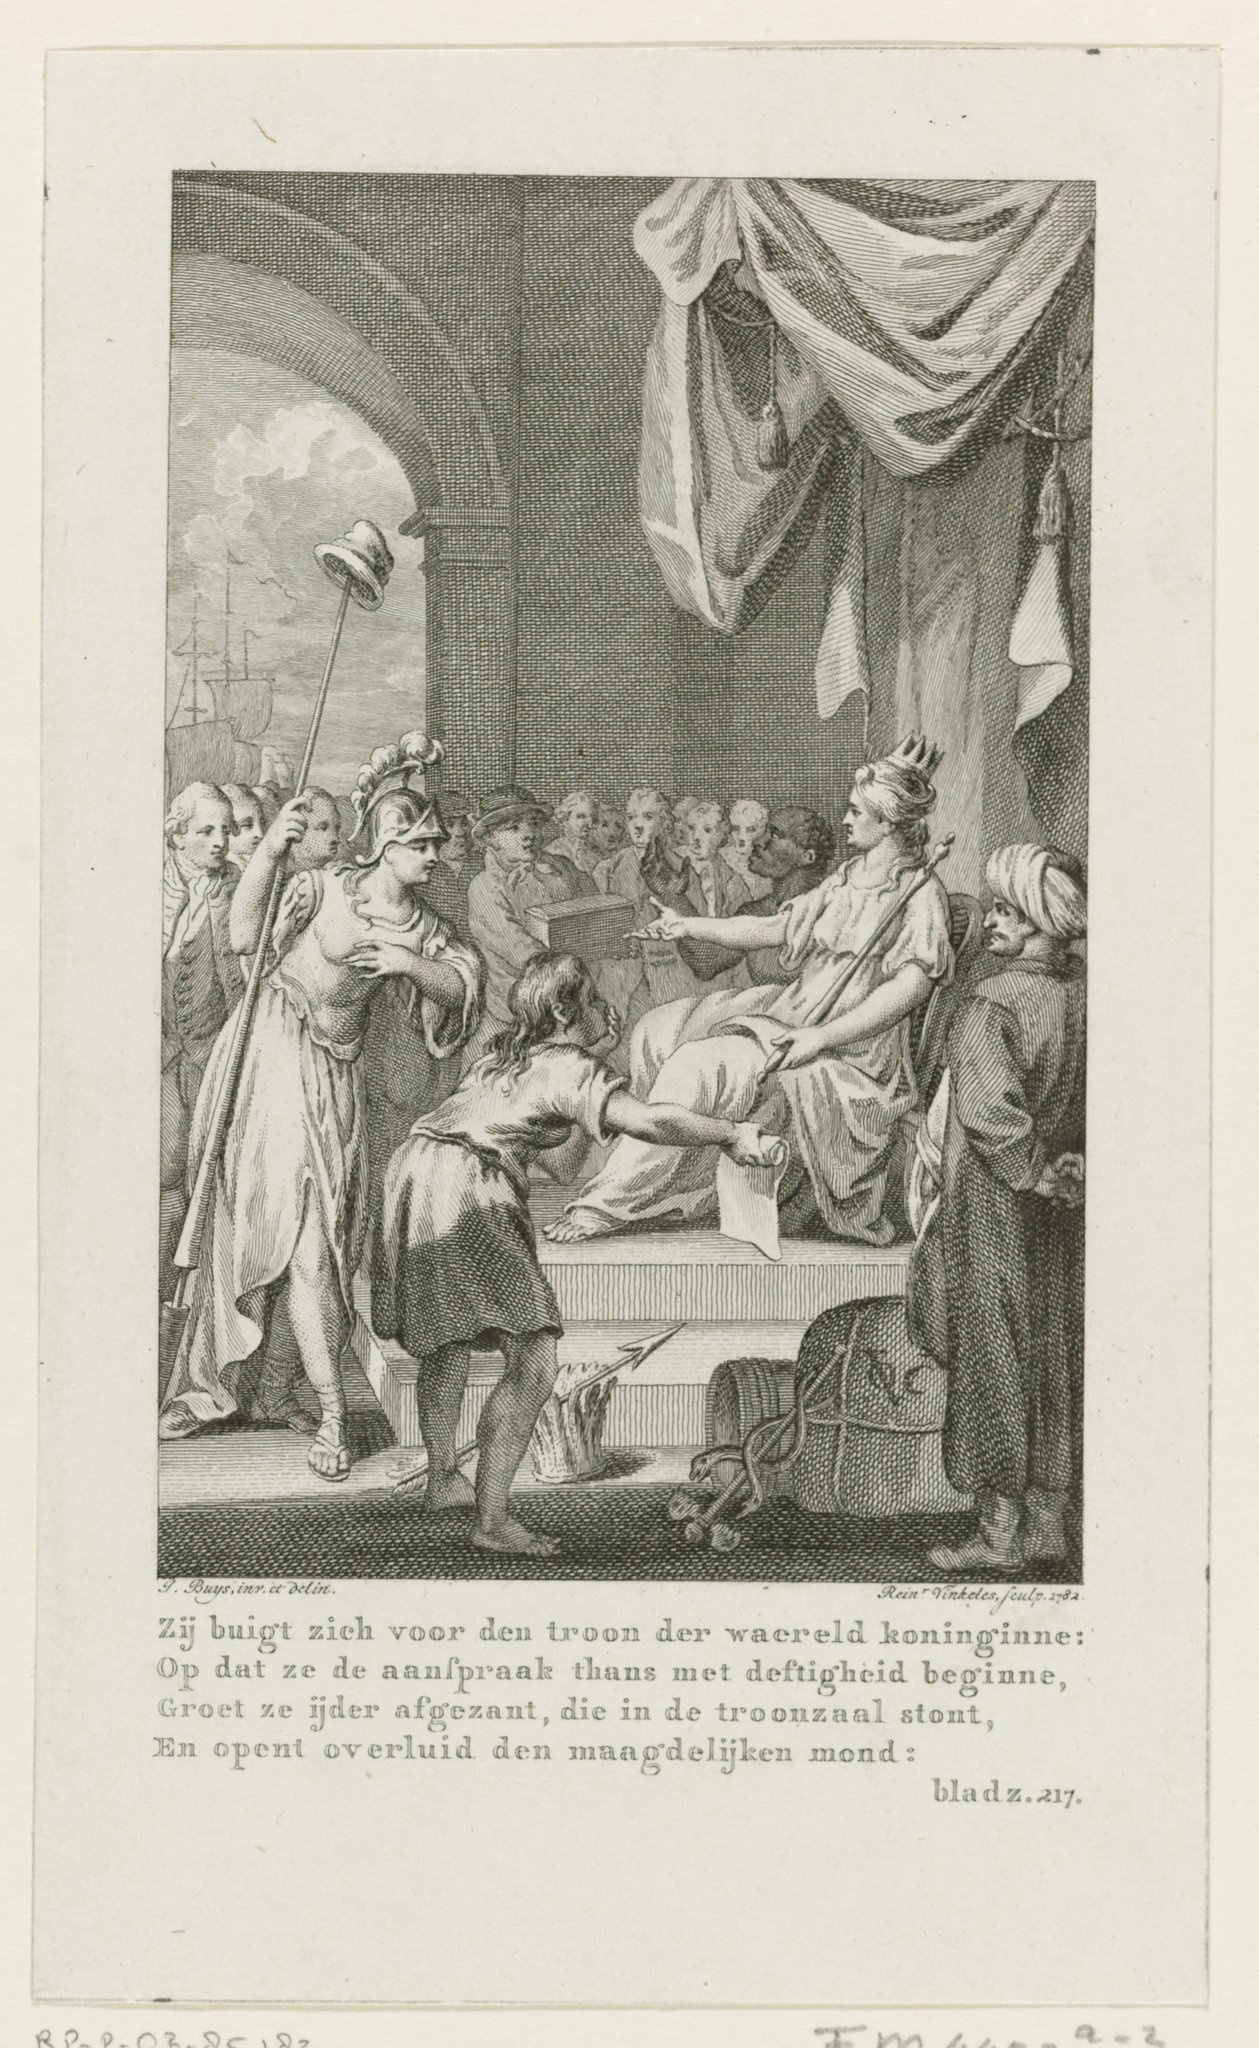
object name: print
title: De Nederlandse Maagd bericht over de overwinning, 1781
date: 1782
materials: paper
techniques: engraving, etching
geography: northern netherlands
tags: personifications of countries, nations, states, districts, etc., netherlands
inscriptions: collector's mark: Lugt 2228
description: Allegorie op de Zeeslag bij Doggersbank tussen de Nederlandse en de Britse vloot op 5 augustus 1781. De Nederlandse Maagd bericht aan de zittende vrouwelijke personificatie van de Wereld over de overwinning in de zeeslag. In het onderschrift een vierregelig vers en de verwijzing naar blz. 217.